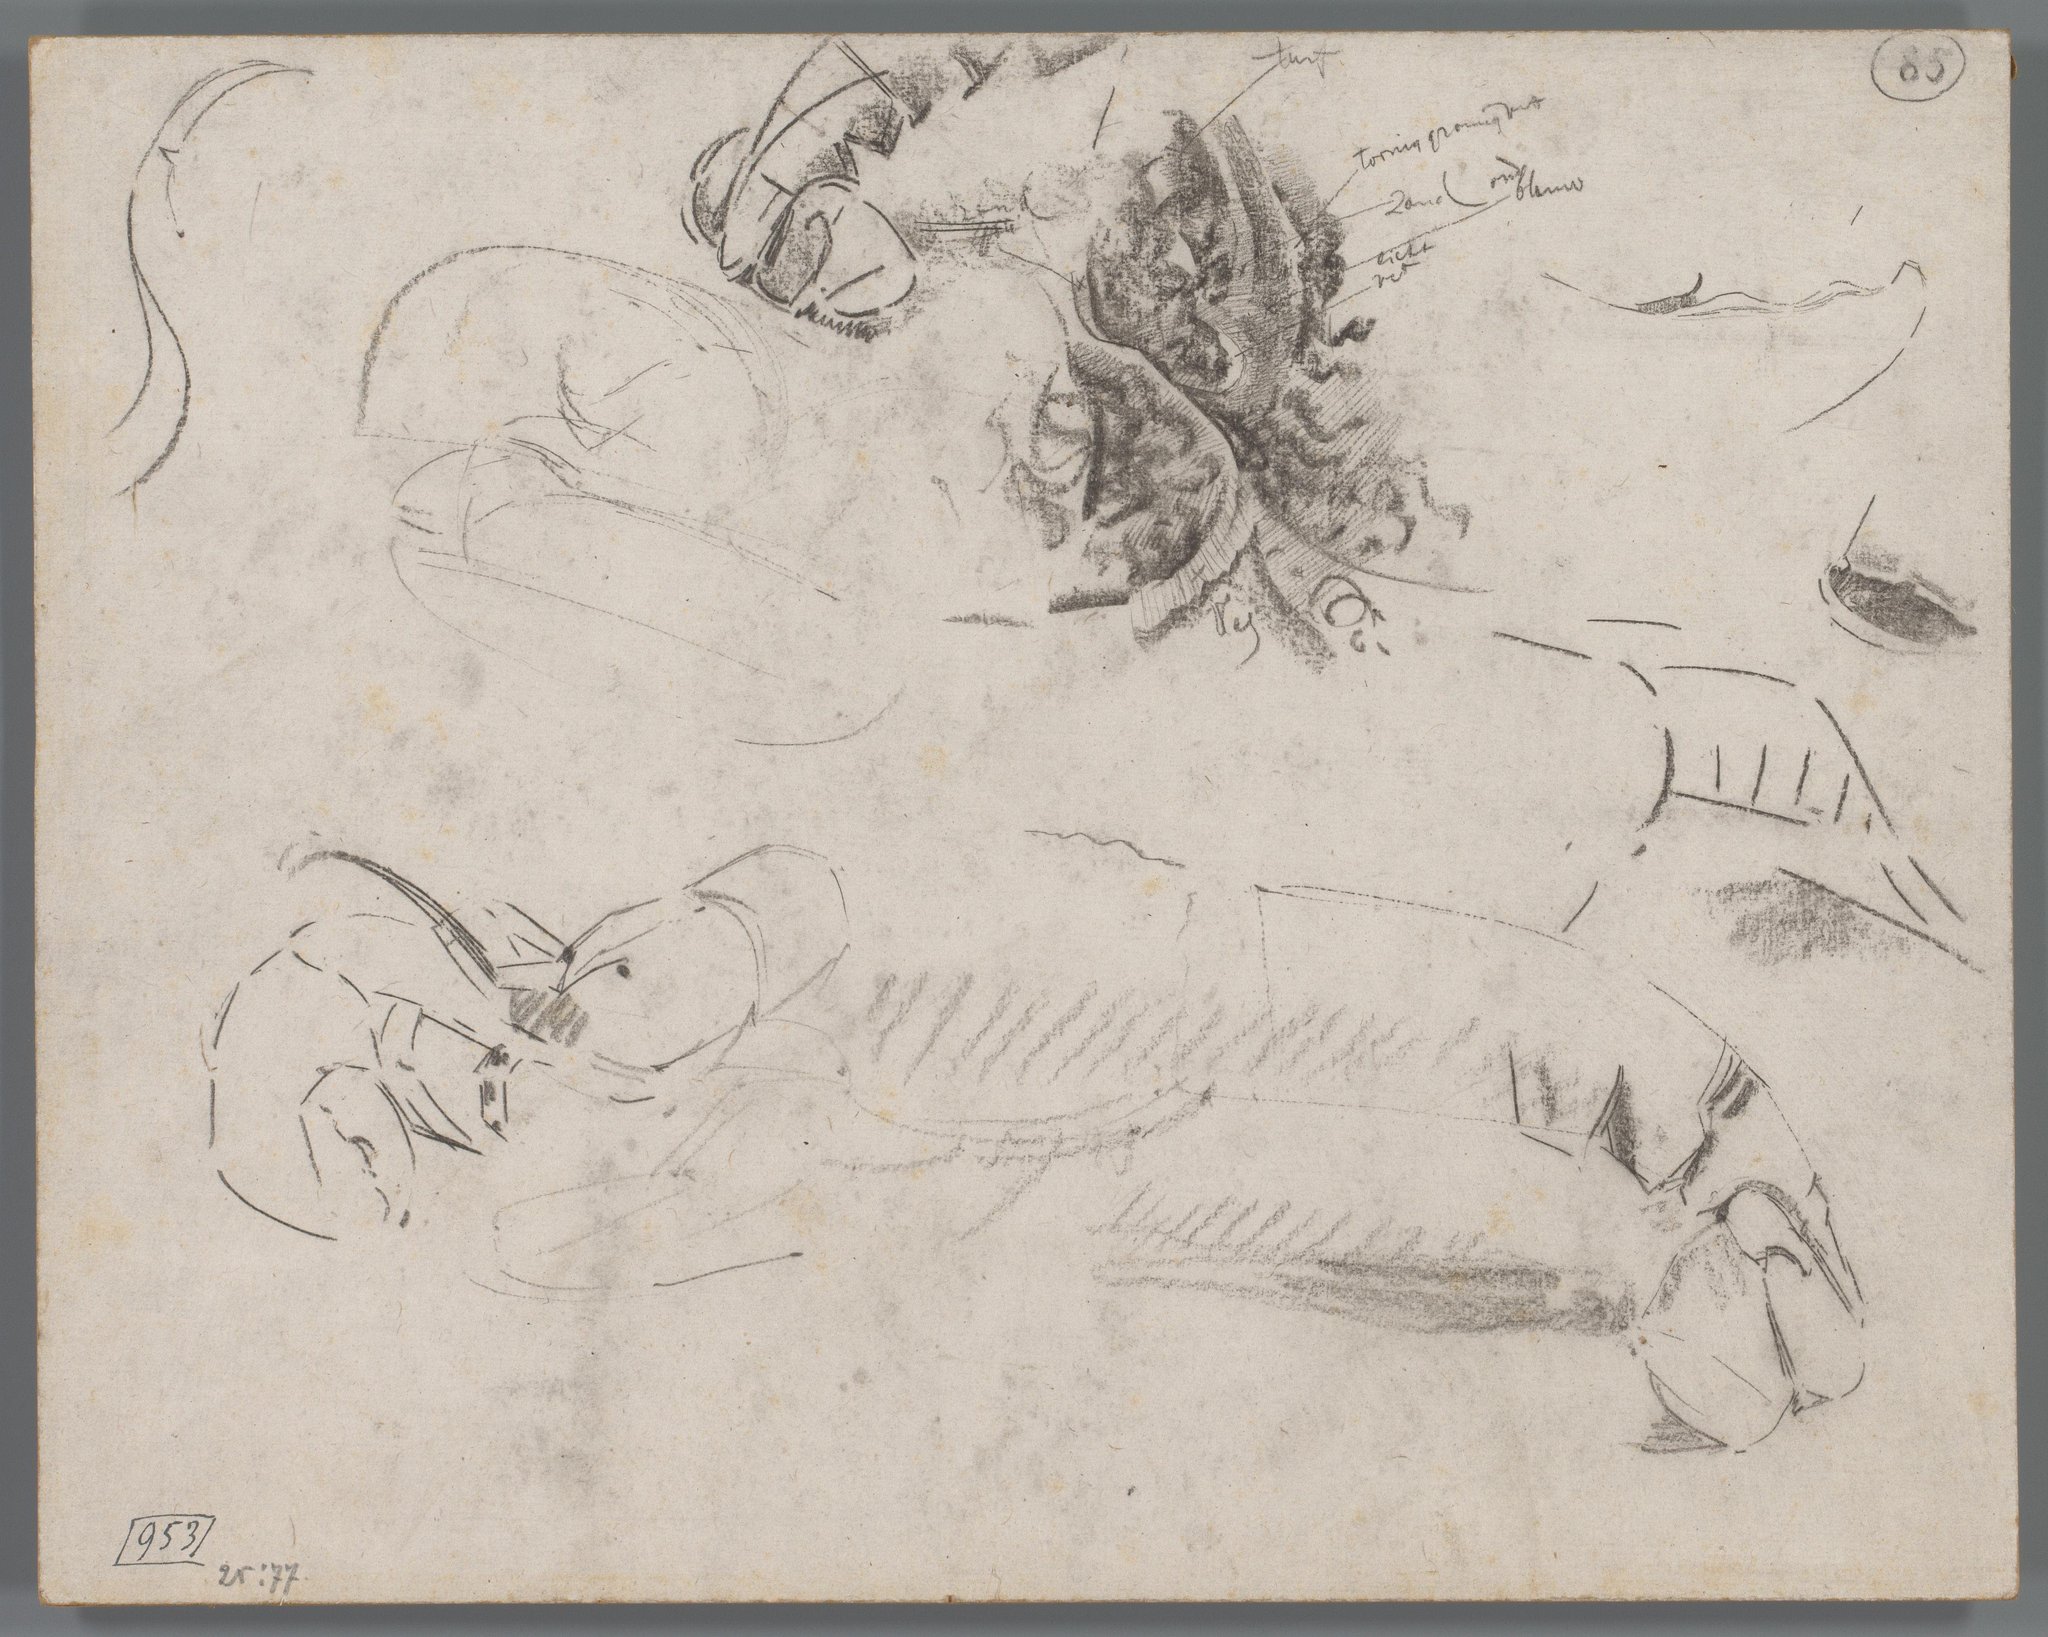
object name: drawing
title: Studies van kreeften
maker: gerrit willem dijsselhof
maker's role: designer, draughtsman, print maker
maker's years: 1866-1924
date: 1876-1924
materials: cardboard, chalk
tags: crustaceans: lobster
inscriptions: number: ‘85’, number: ‘953’